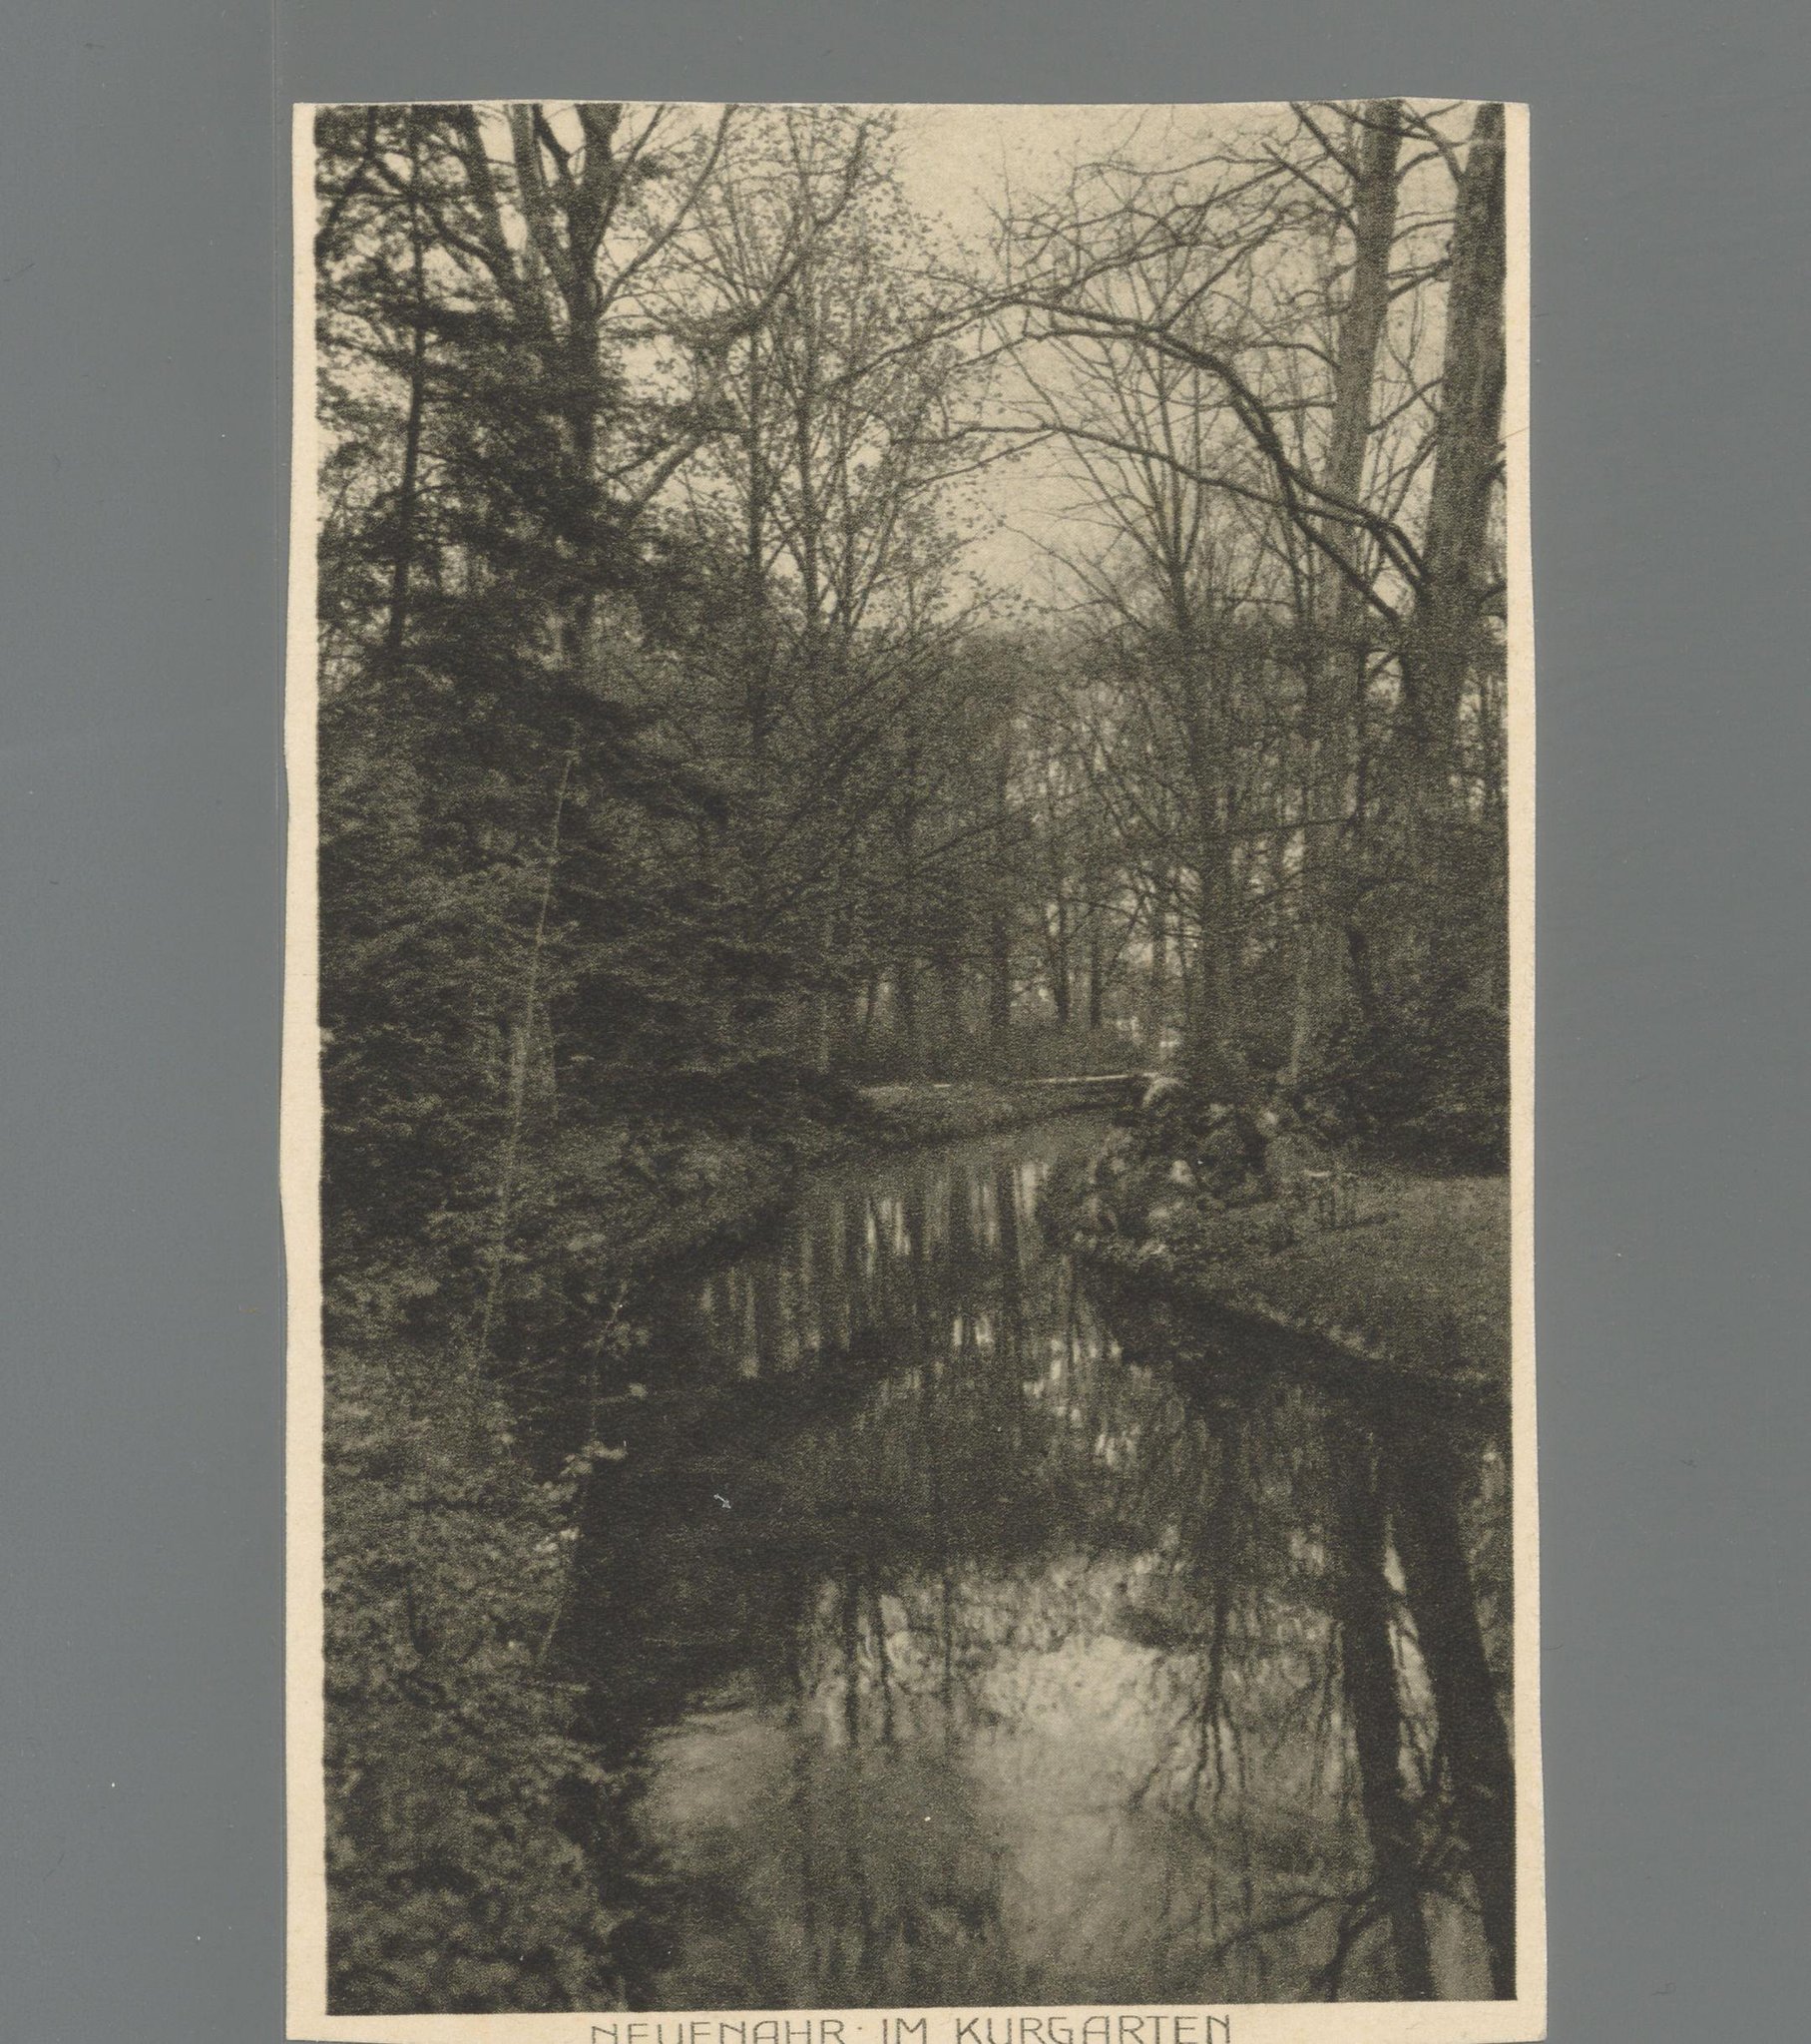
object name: photomechanical print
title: Neuenahr: im Kurgarten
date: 1905-1930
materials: cardboard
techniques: rotogravure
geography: bad neuenahr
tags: river, watering-place, spa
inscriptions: monogram: ‘K.T.F.’